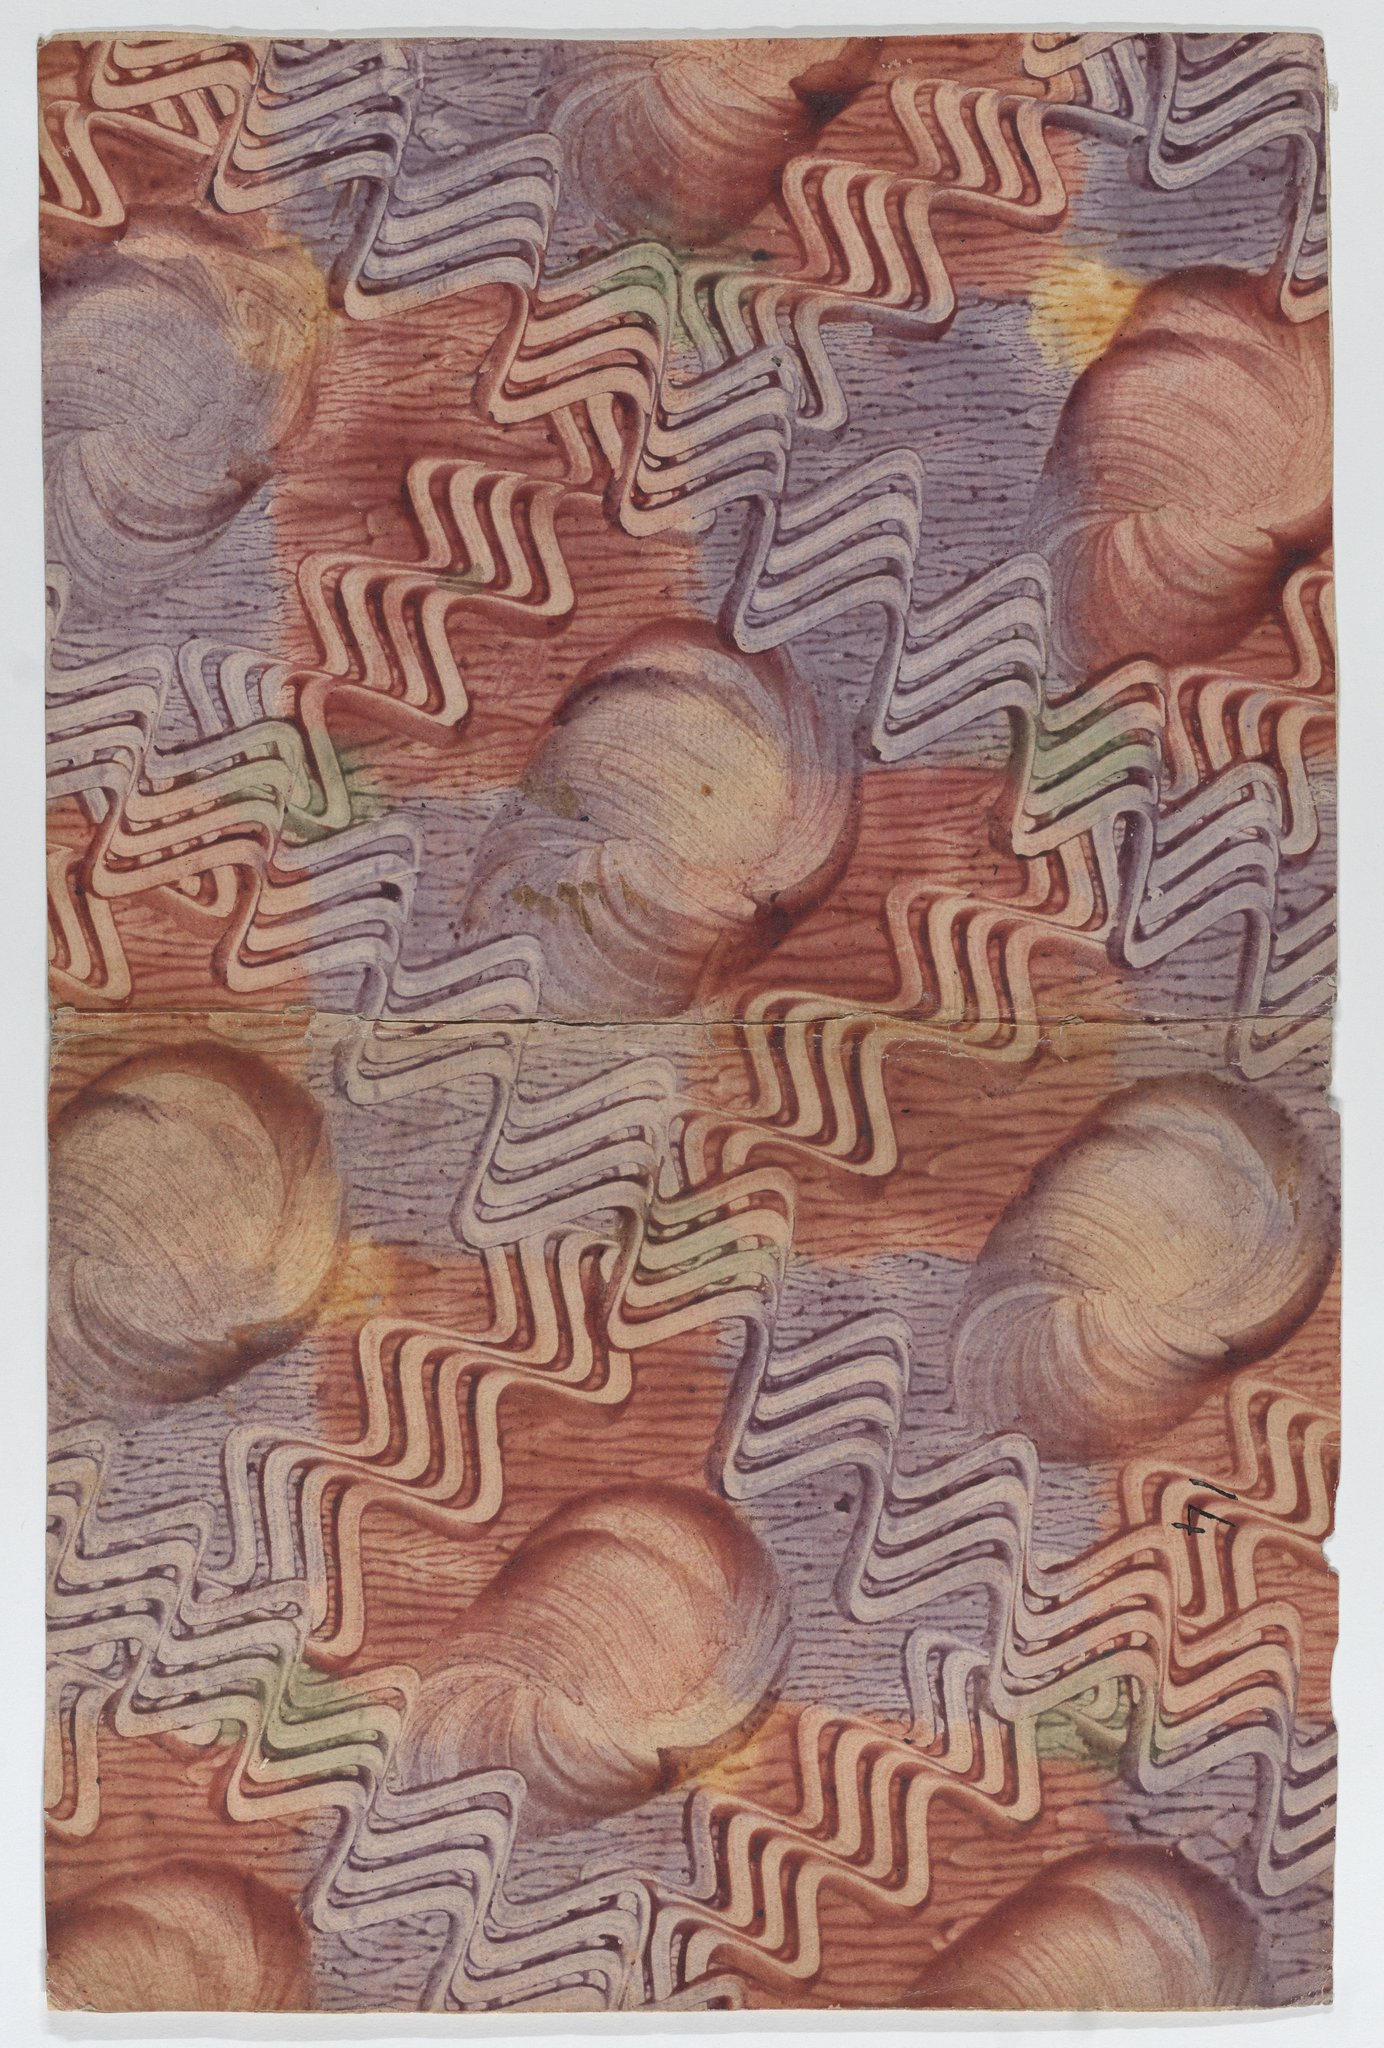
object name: print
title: Book cover with zigzag stripe pattern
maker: Anonymous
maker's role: artist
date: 1701-1800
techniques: relief print